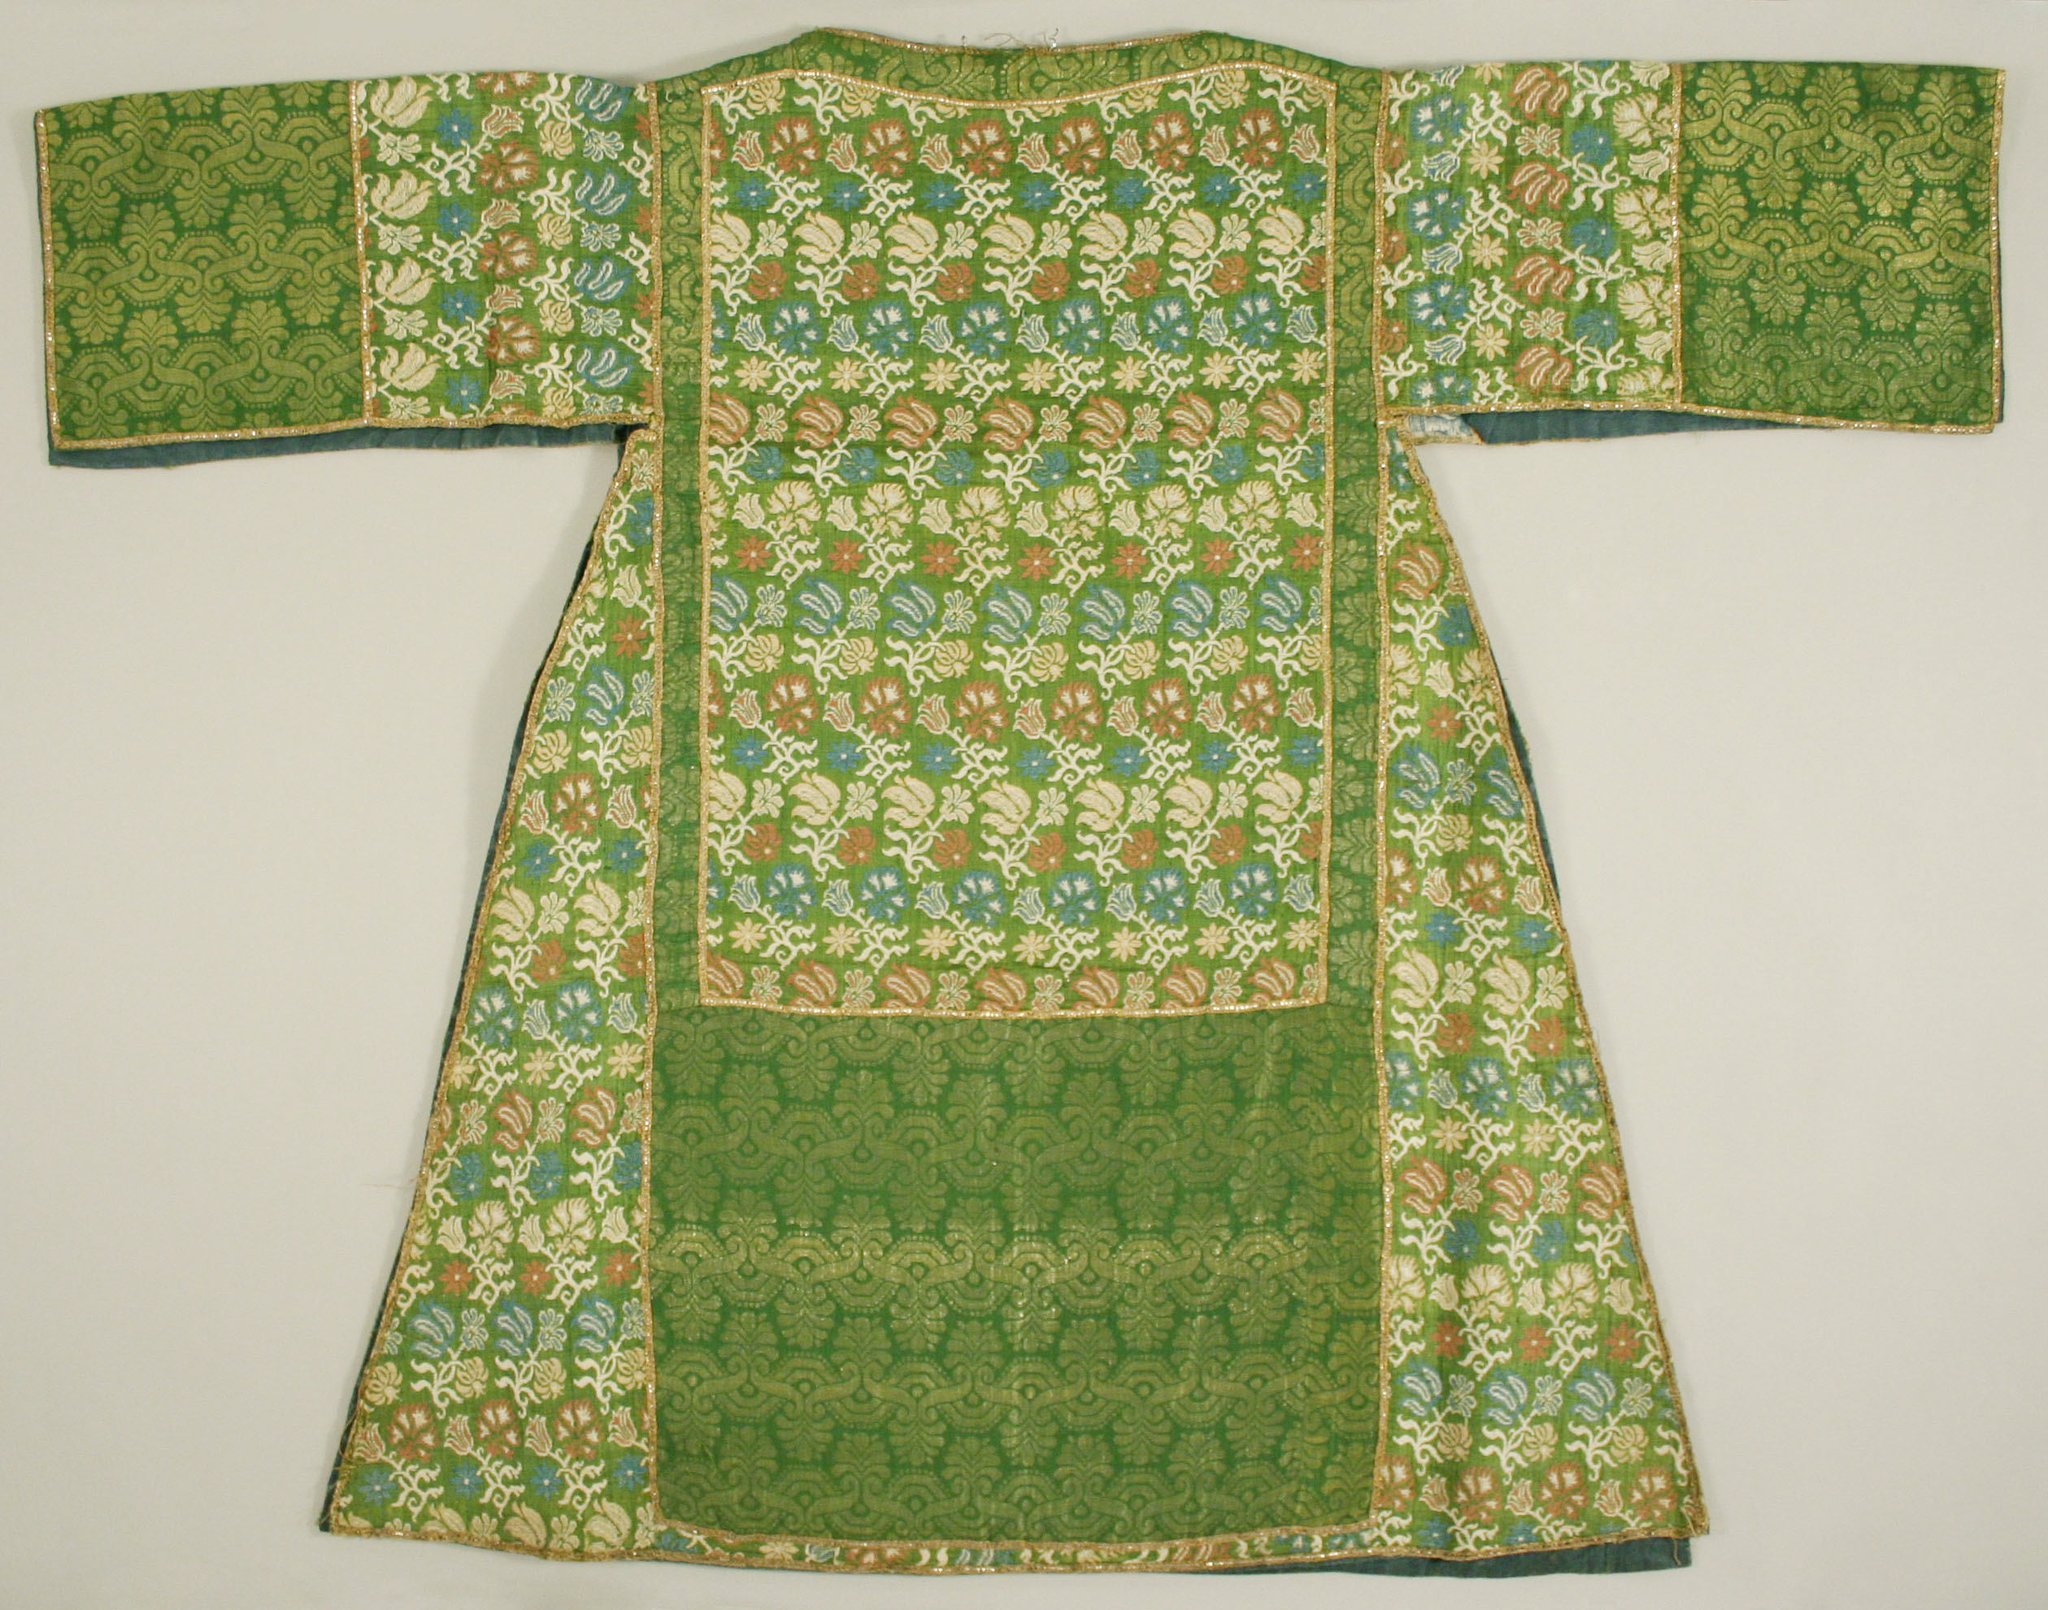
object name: ensemble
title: Set of vestments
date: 1500-1625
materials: silk, wool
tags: flowers